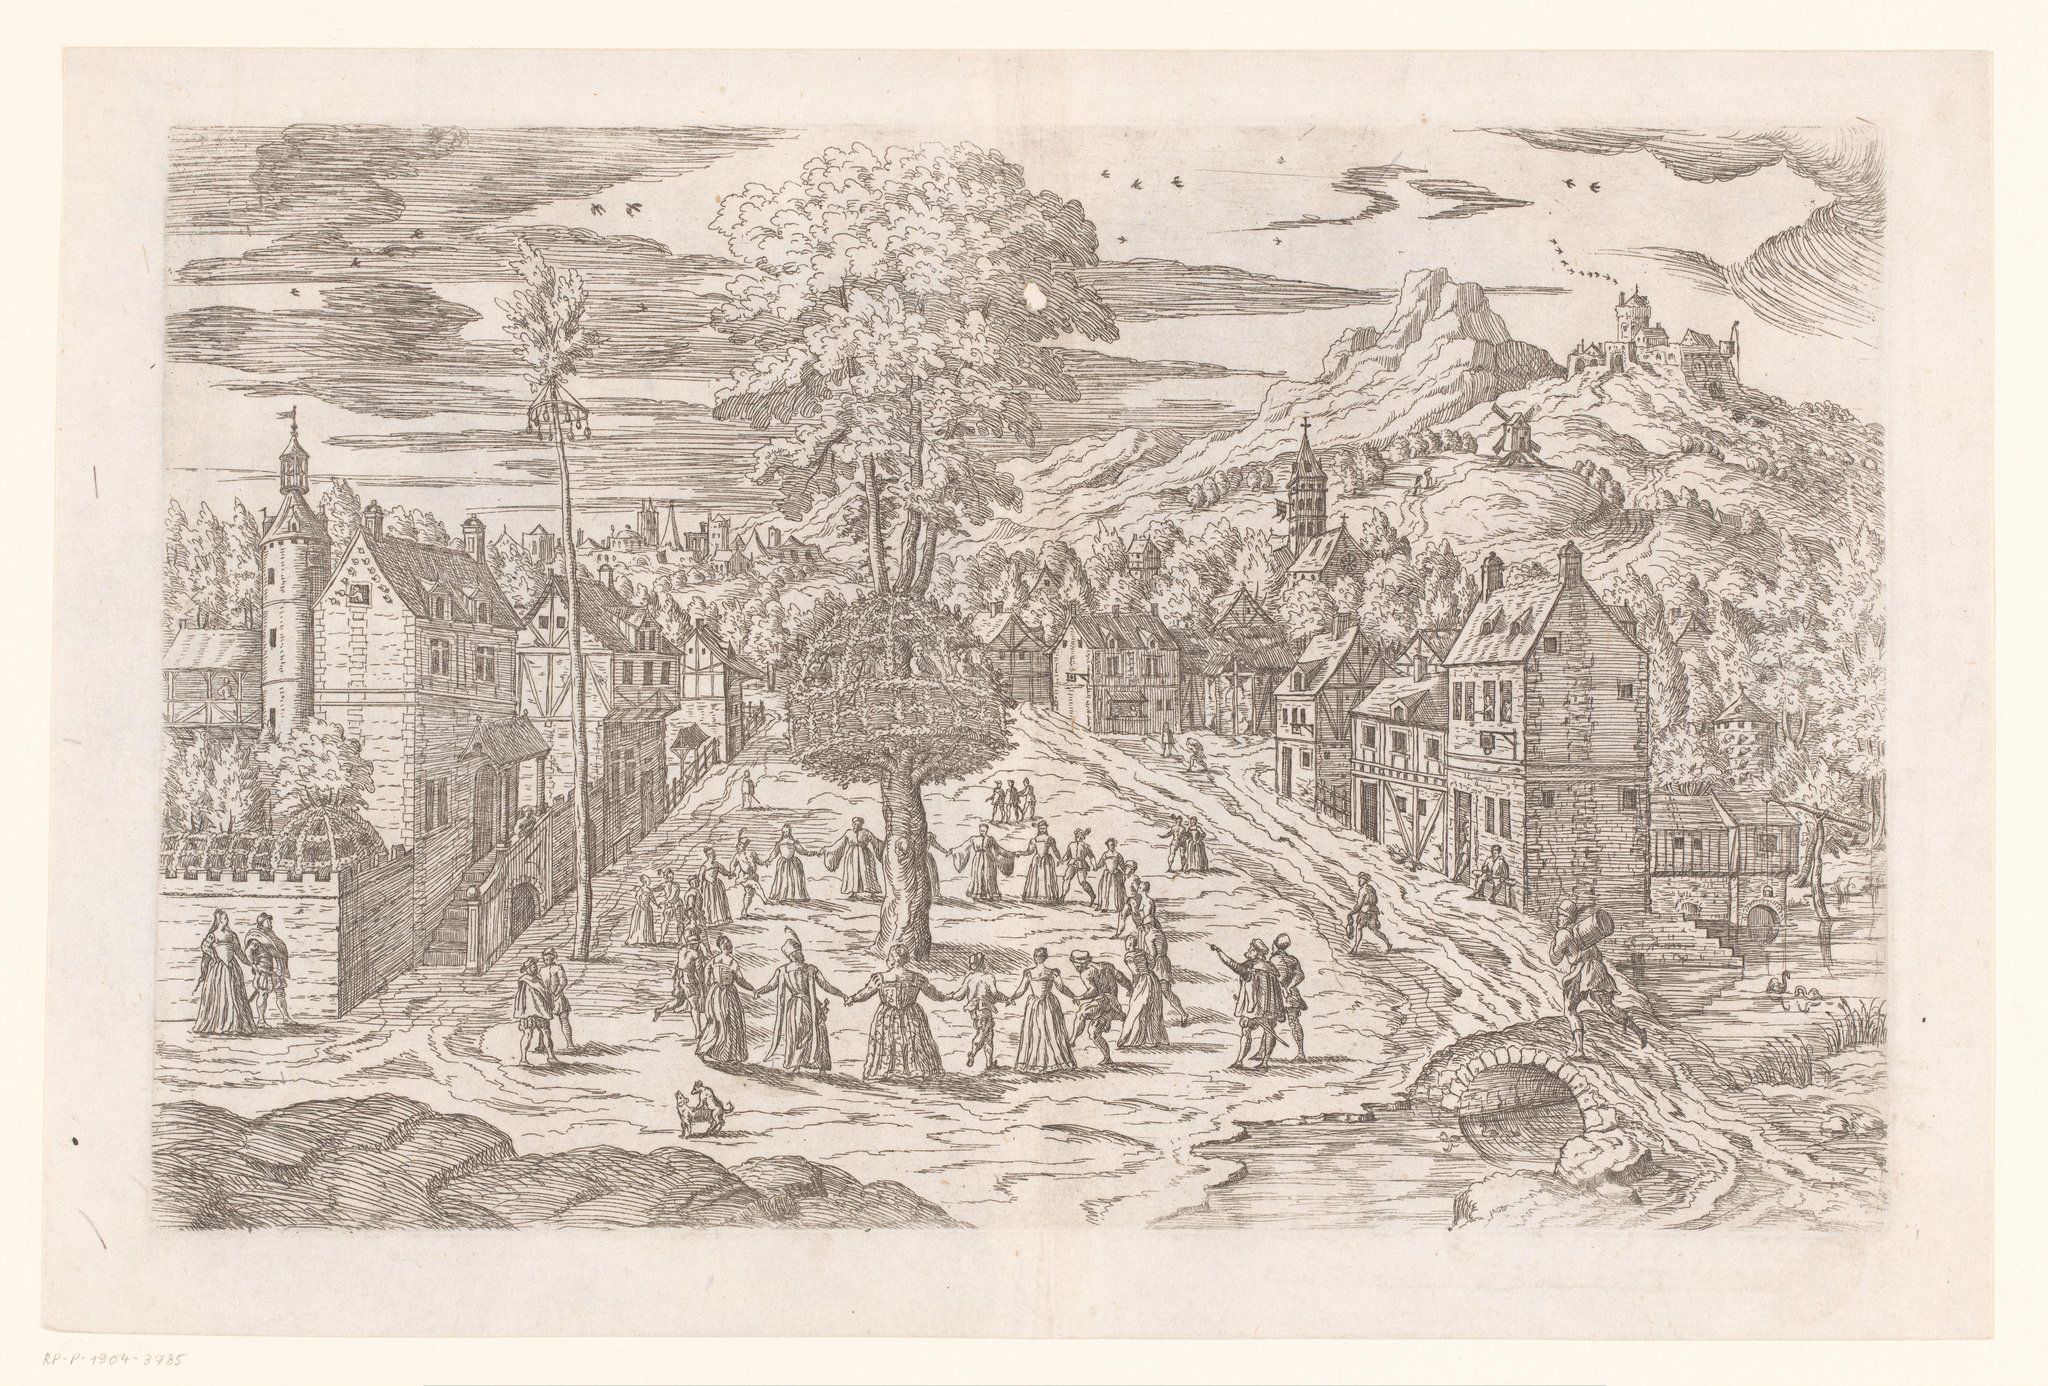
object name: print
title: Meifeest op een dorpsplein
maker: etienne dupérac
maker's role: draughtsman, painter, print maker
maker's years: 1525-1604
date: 1535-1604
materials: paper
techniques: etching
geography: france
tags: landscape symbolizing may, trees, village square, place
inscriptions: collector's mark: Lugt 2228